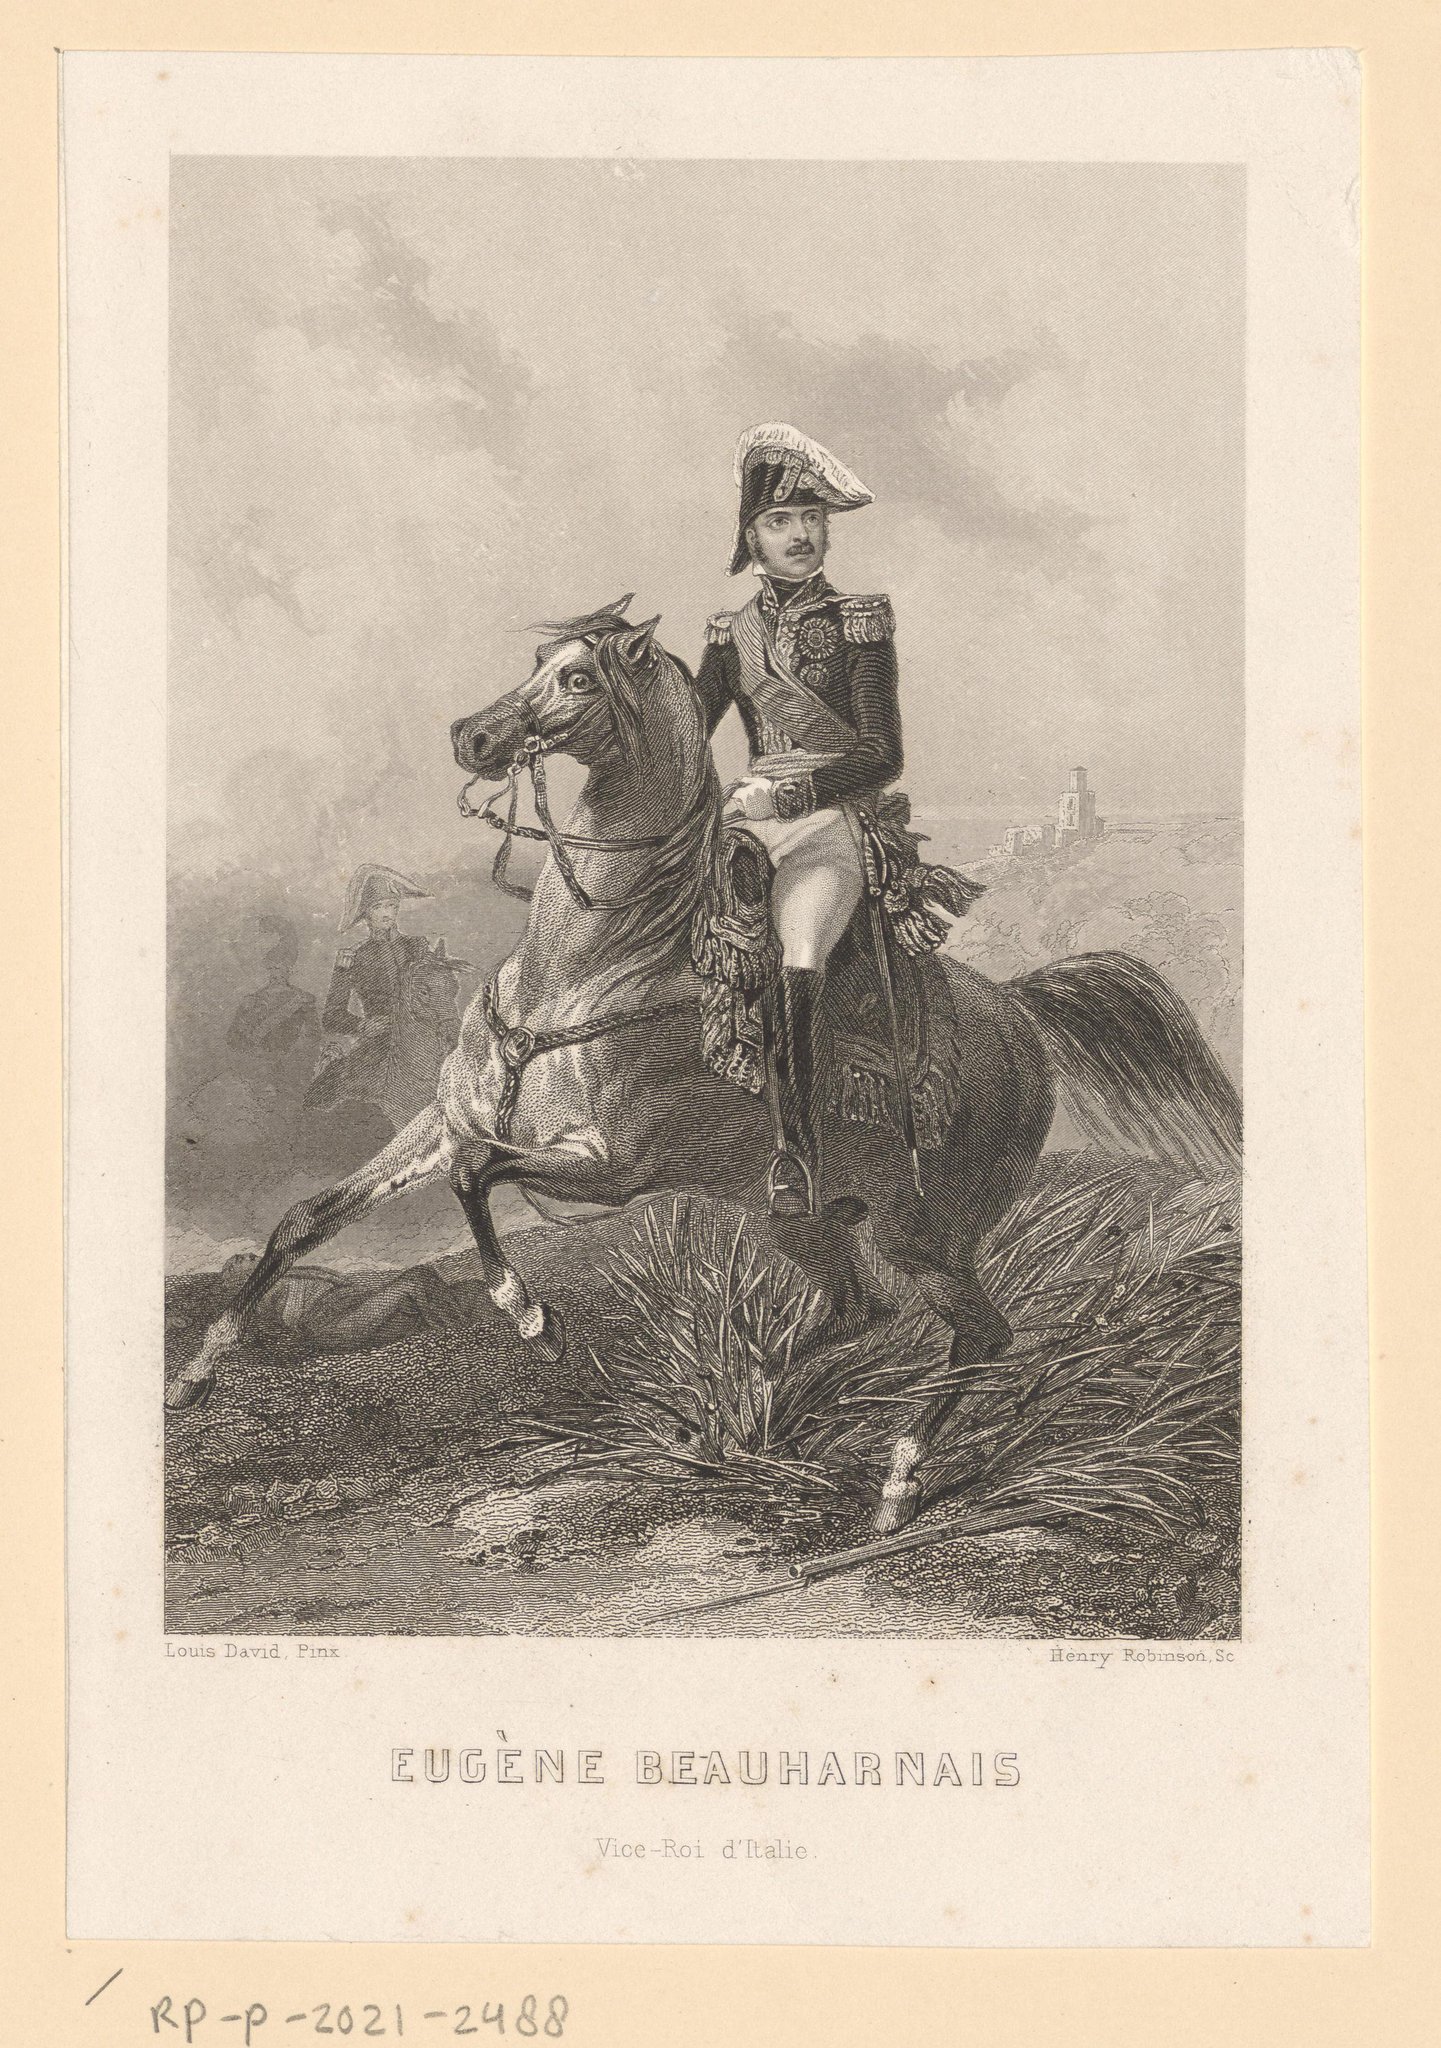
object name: print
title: Portret van Eugène de Beauharnais, hertog van Leuchtenberg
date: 1827-1872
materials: paper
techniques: engraving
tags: eugène de beauharnais, riding a horse, ass, or mule; rider, horseman, historical persons, (military) uniforms